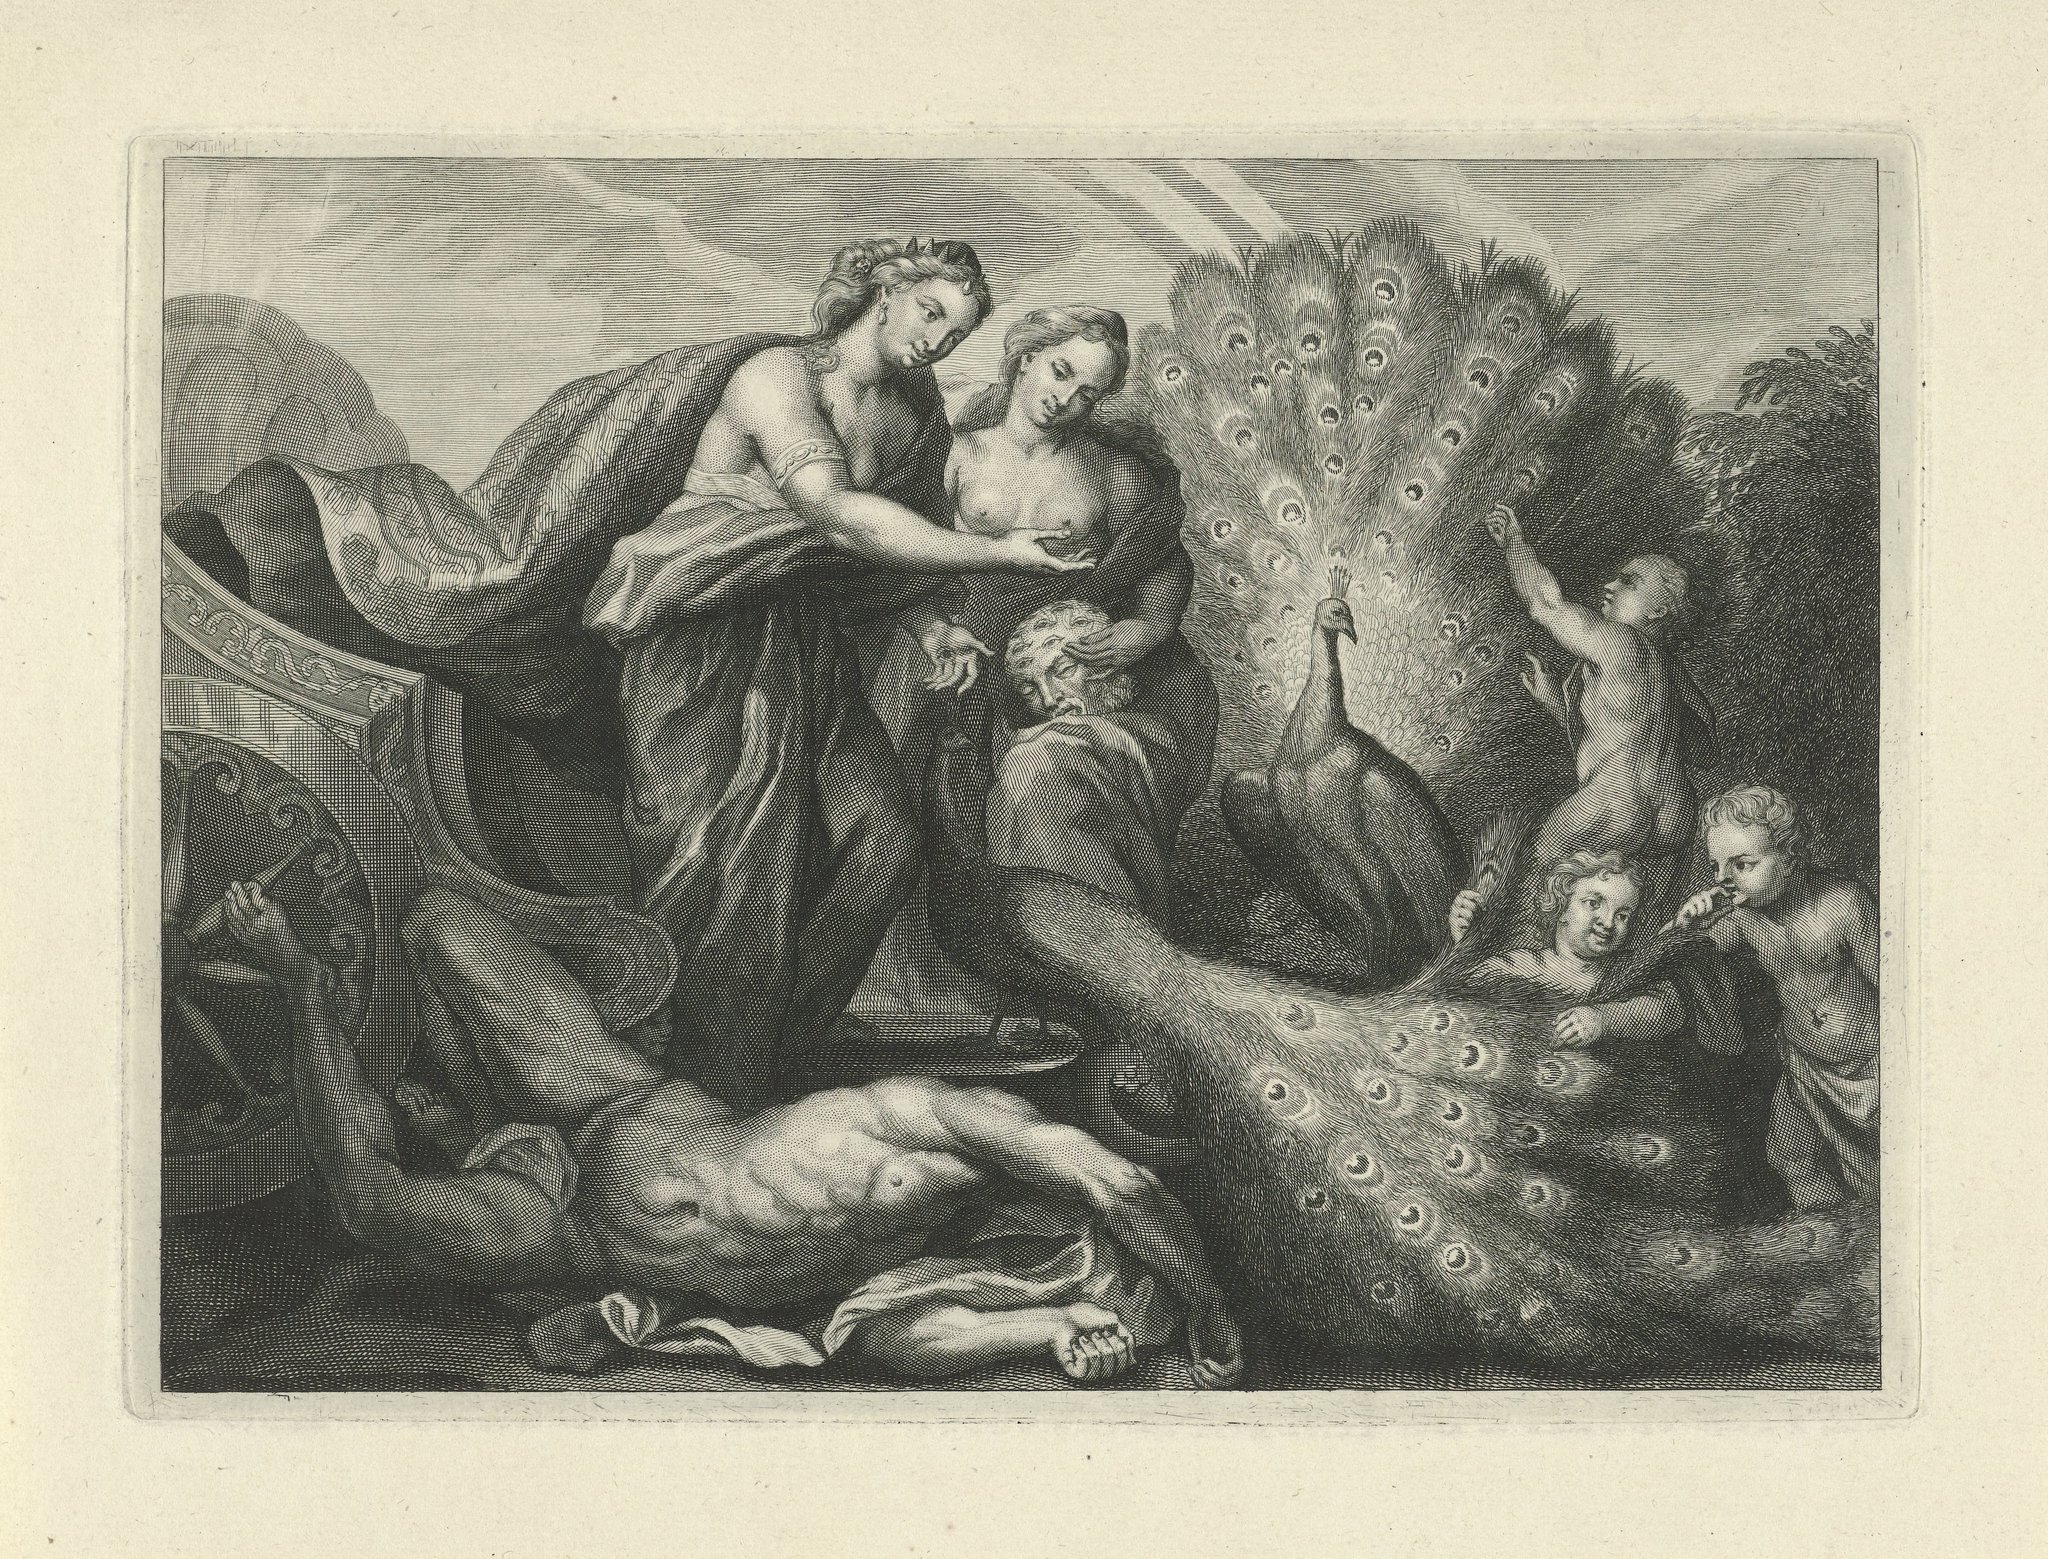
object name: print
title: Juno zet de ogen van Argus in de staart van haar pauw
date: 1685-1732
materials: paper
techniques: engraving, etching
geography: amsterdam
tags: cupids: 'amores', 'amoretti', 'putti', argus' eyes changed into peacock's 'eyes' (ocelli): juno sets argus' eyes on her peacock, after argus, while watching io, has been slain by mercury (ovid, metamorphoses i 723)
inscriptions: collector's mark: Lugt 2228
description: Juno staat naast het onthoofde lijk van Argus. Een van haar nimfen heeft het hoofd van Argus in haar schoot. Juno neemt de ogen uit het hoofd en zet ze een voor een in de staart van haar pauw. Drie putti helpen haar.